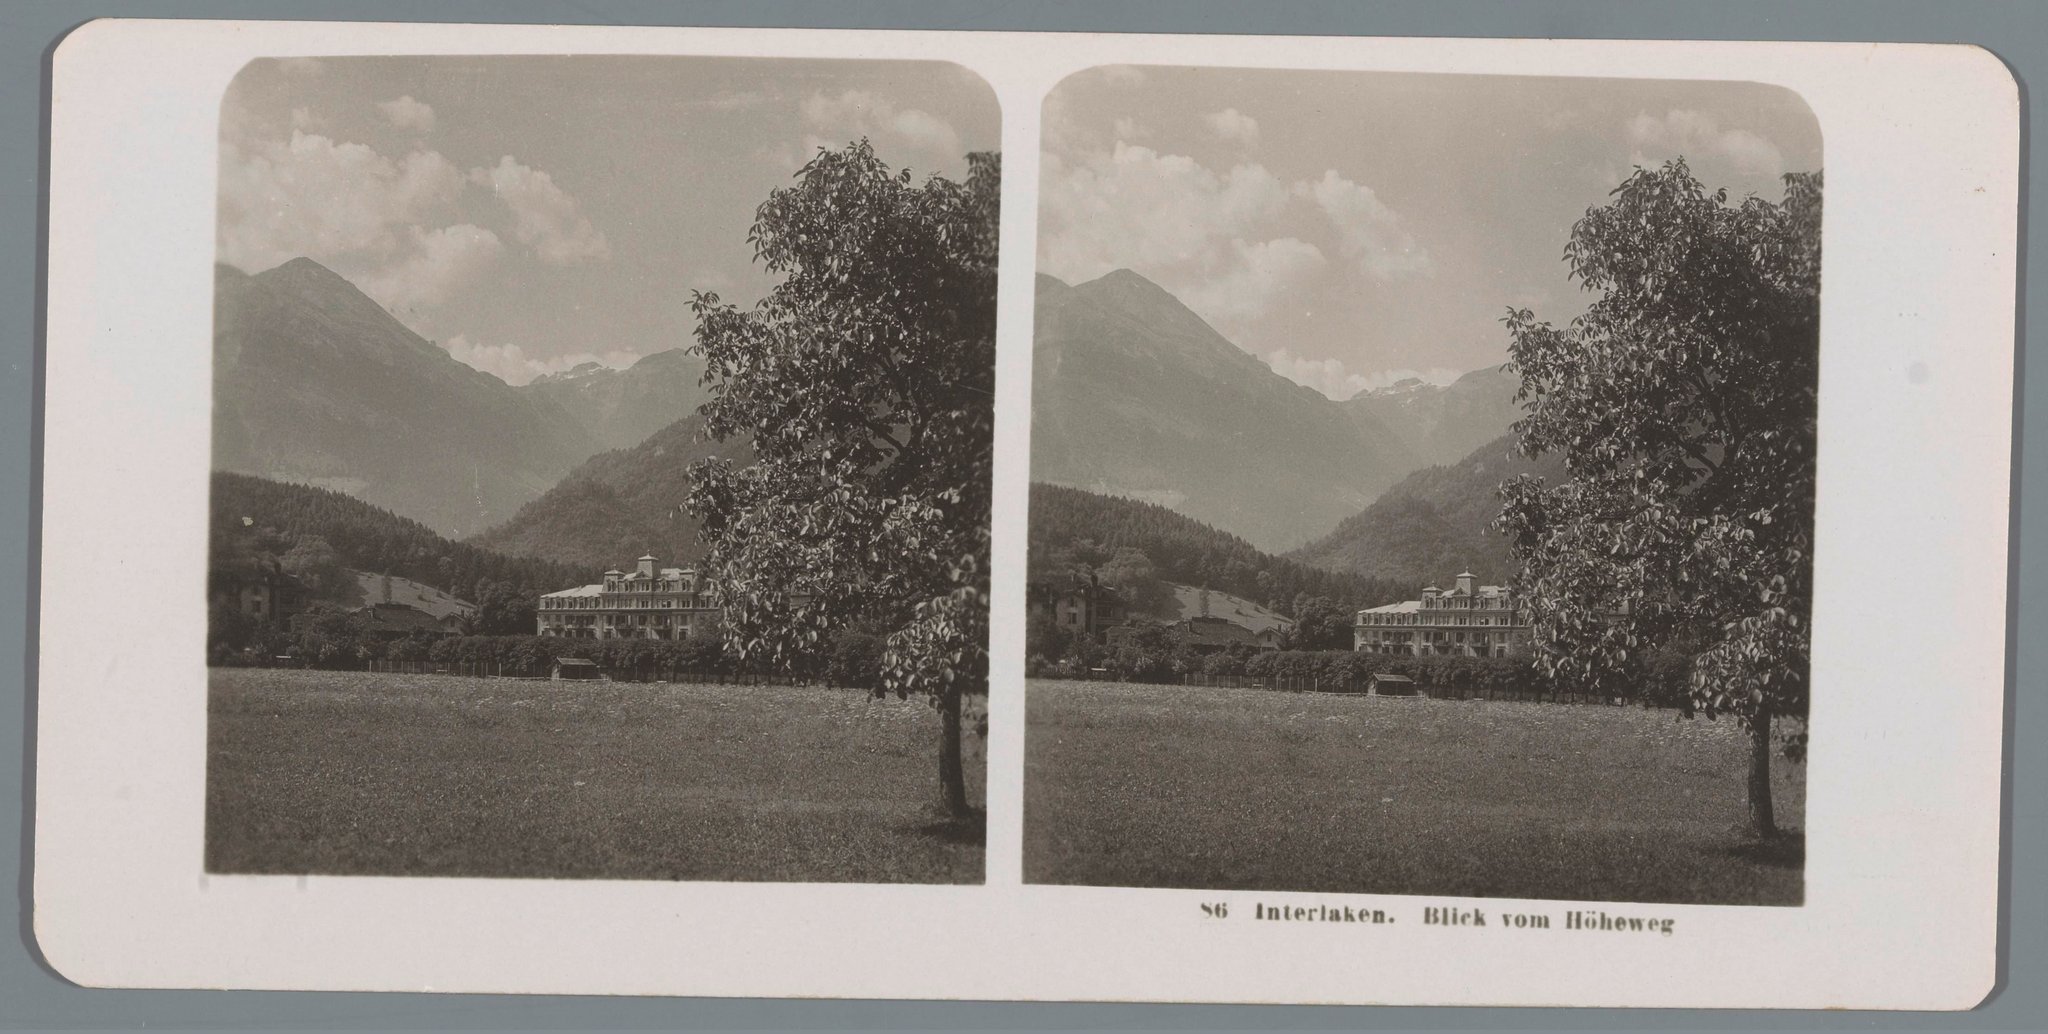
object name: stereograph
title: Interlaken. Blick vom Höheweg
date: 1906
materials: cardboard, photographic support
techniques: gelatin silver print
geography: bern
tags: façade (of house or building), mountains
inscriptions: number: ‘86’, inscription: ‘Neue Photographische Gesellschaft A. G., Steglitz-Berlin 1906.’